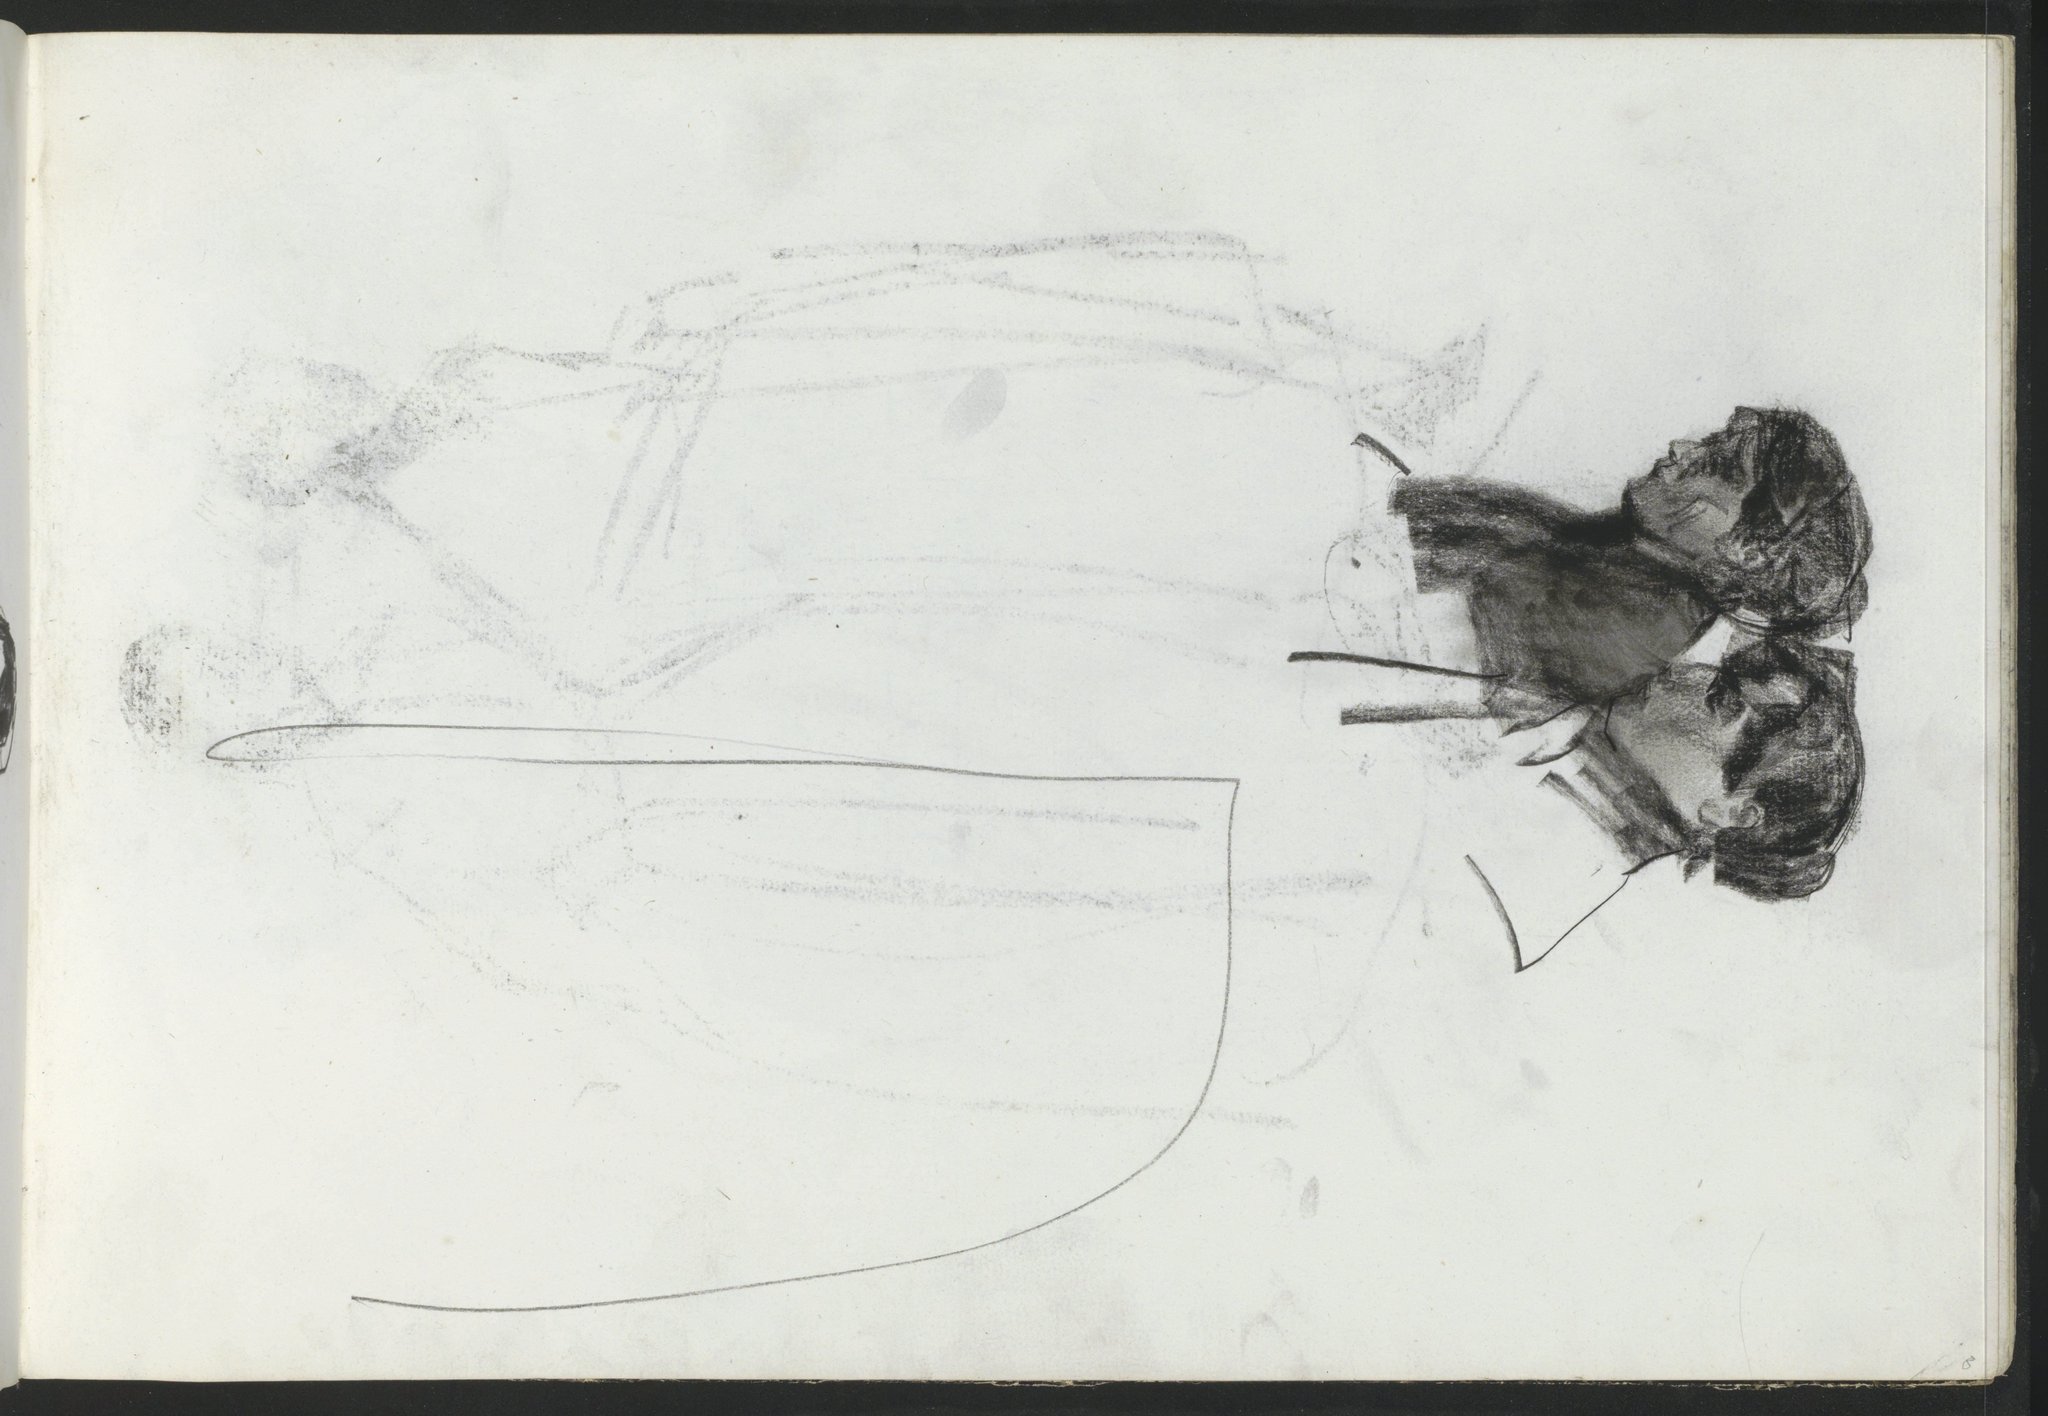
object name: sketchbook leaf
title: Twee jonge vrouwen, in profiel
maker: isaac israels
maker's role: draughtsman, painter, print maker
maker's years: 1865-1934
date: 1886-1934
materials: chalk, paper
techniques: stumping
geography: amsterdam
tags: adolescent, young woman, maiden (+ sideview, profile)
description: Blad 8 recto uit schetsboek LXX met 17 bladen.